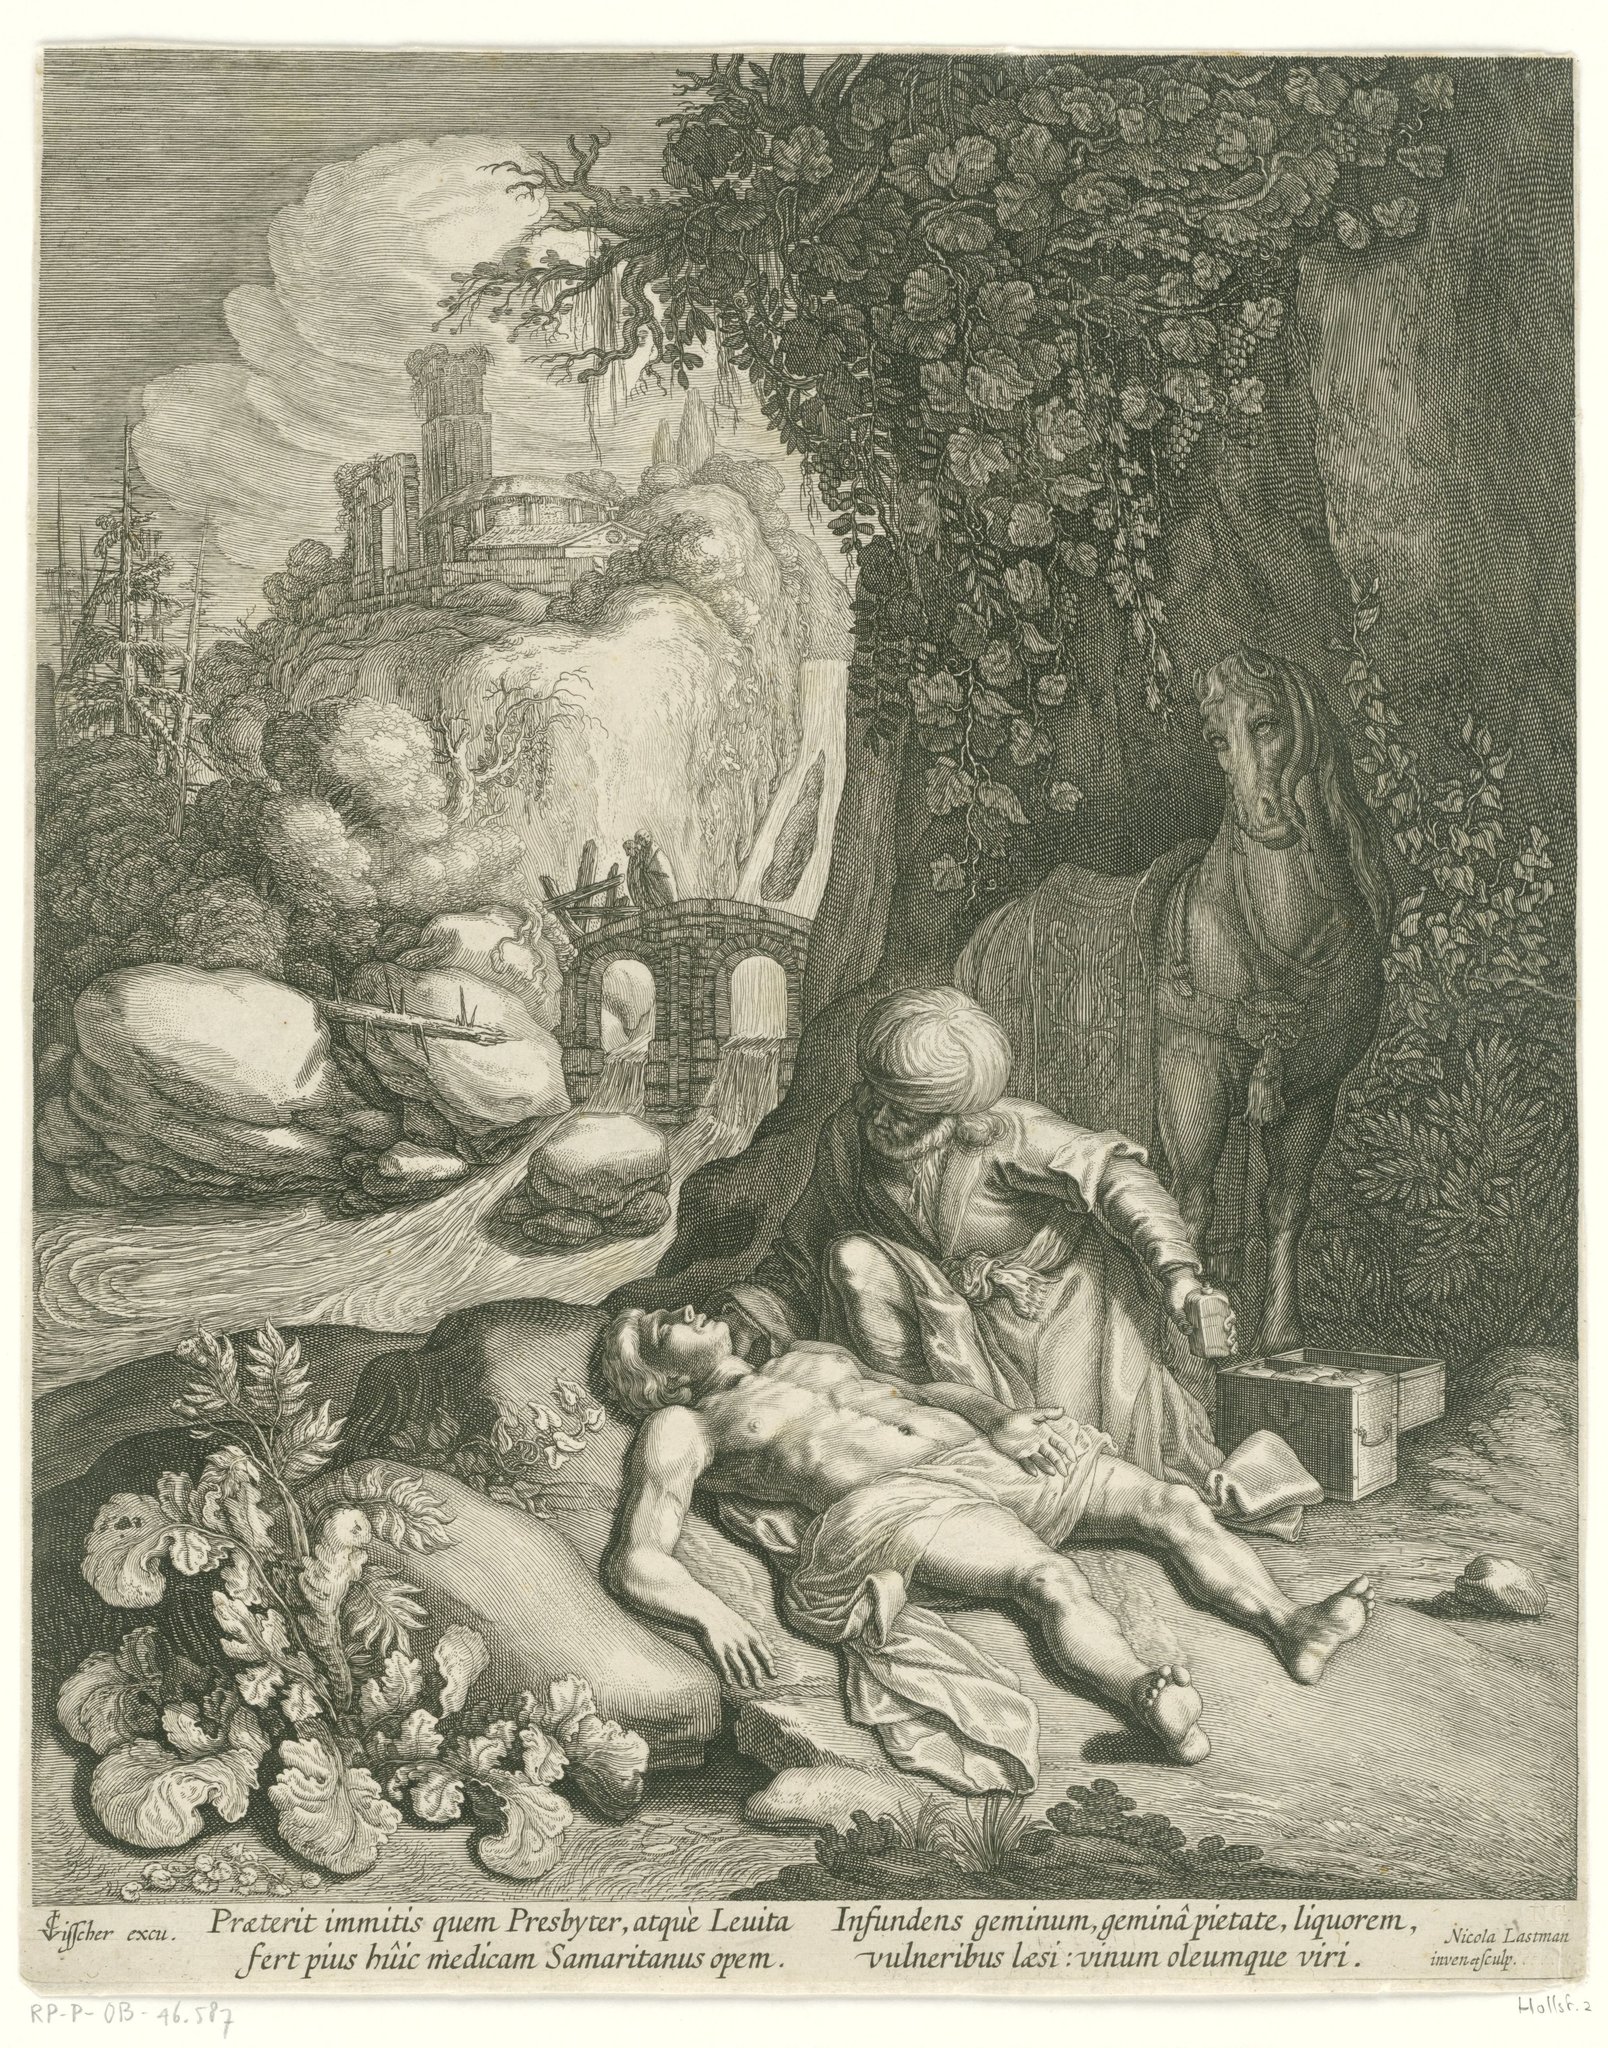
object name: print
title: De barmhartige Samaritaan helpt de gewonde reiziger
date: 1601-1652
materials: paper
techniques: engraving, etching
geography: amsterdam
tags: a samaritan tending the wounds of the traveller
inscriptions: collector's mark: Lugt 2228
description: Landschap met de barmhartige Samaritaan die de wonden van de door struikrovers overvallen man verzorgt. Achter hen staat het paard van de Samaritaan, twee figuren lopen op een brug over de rivier. In de verte een kerk en resten van antieke bouwwerken op een berg. In de marge staat een onderschrift in Latijn.